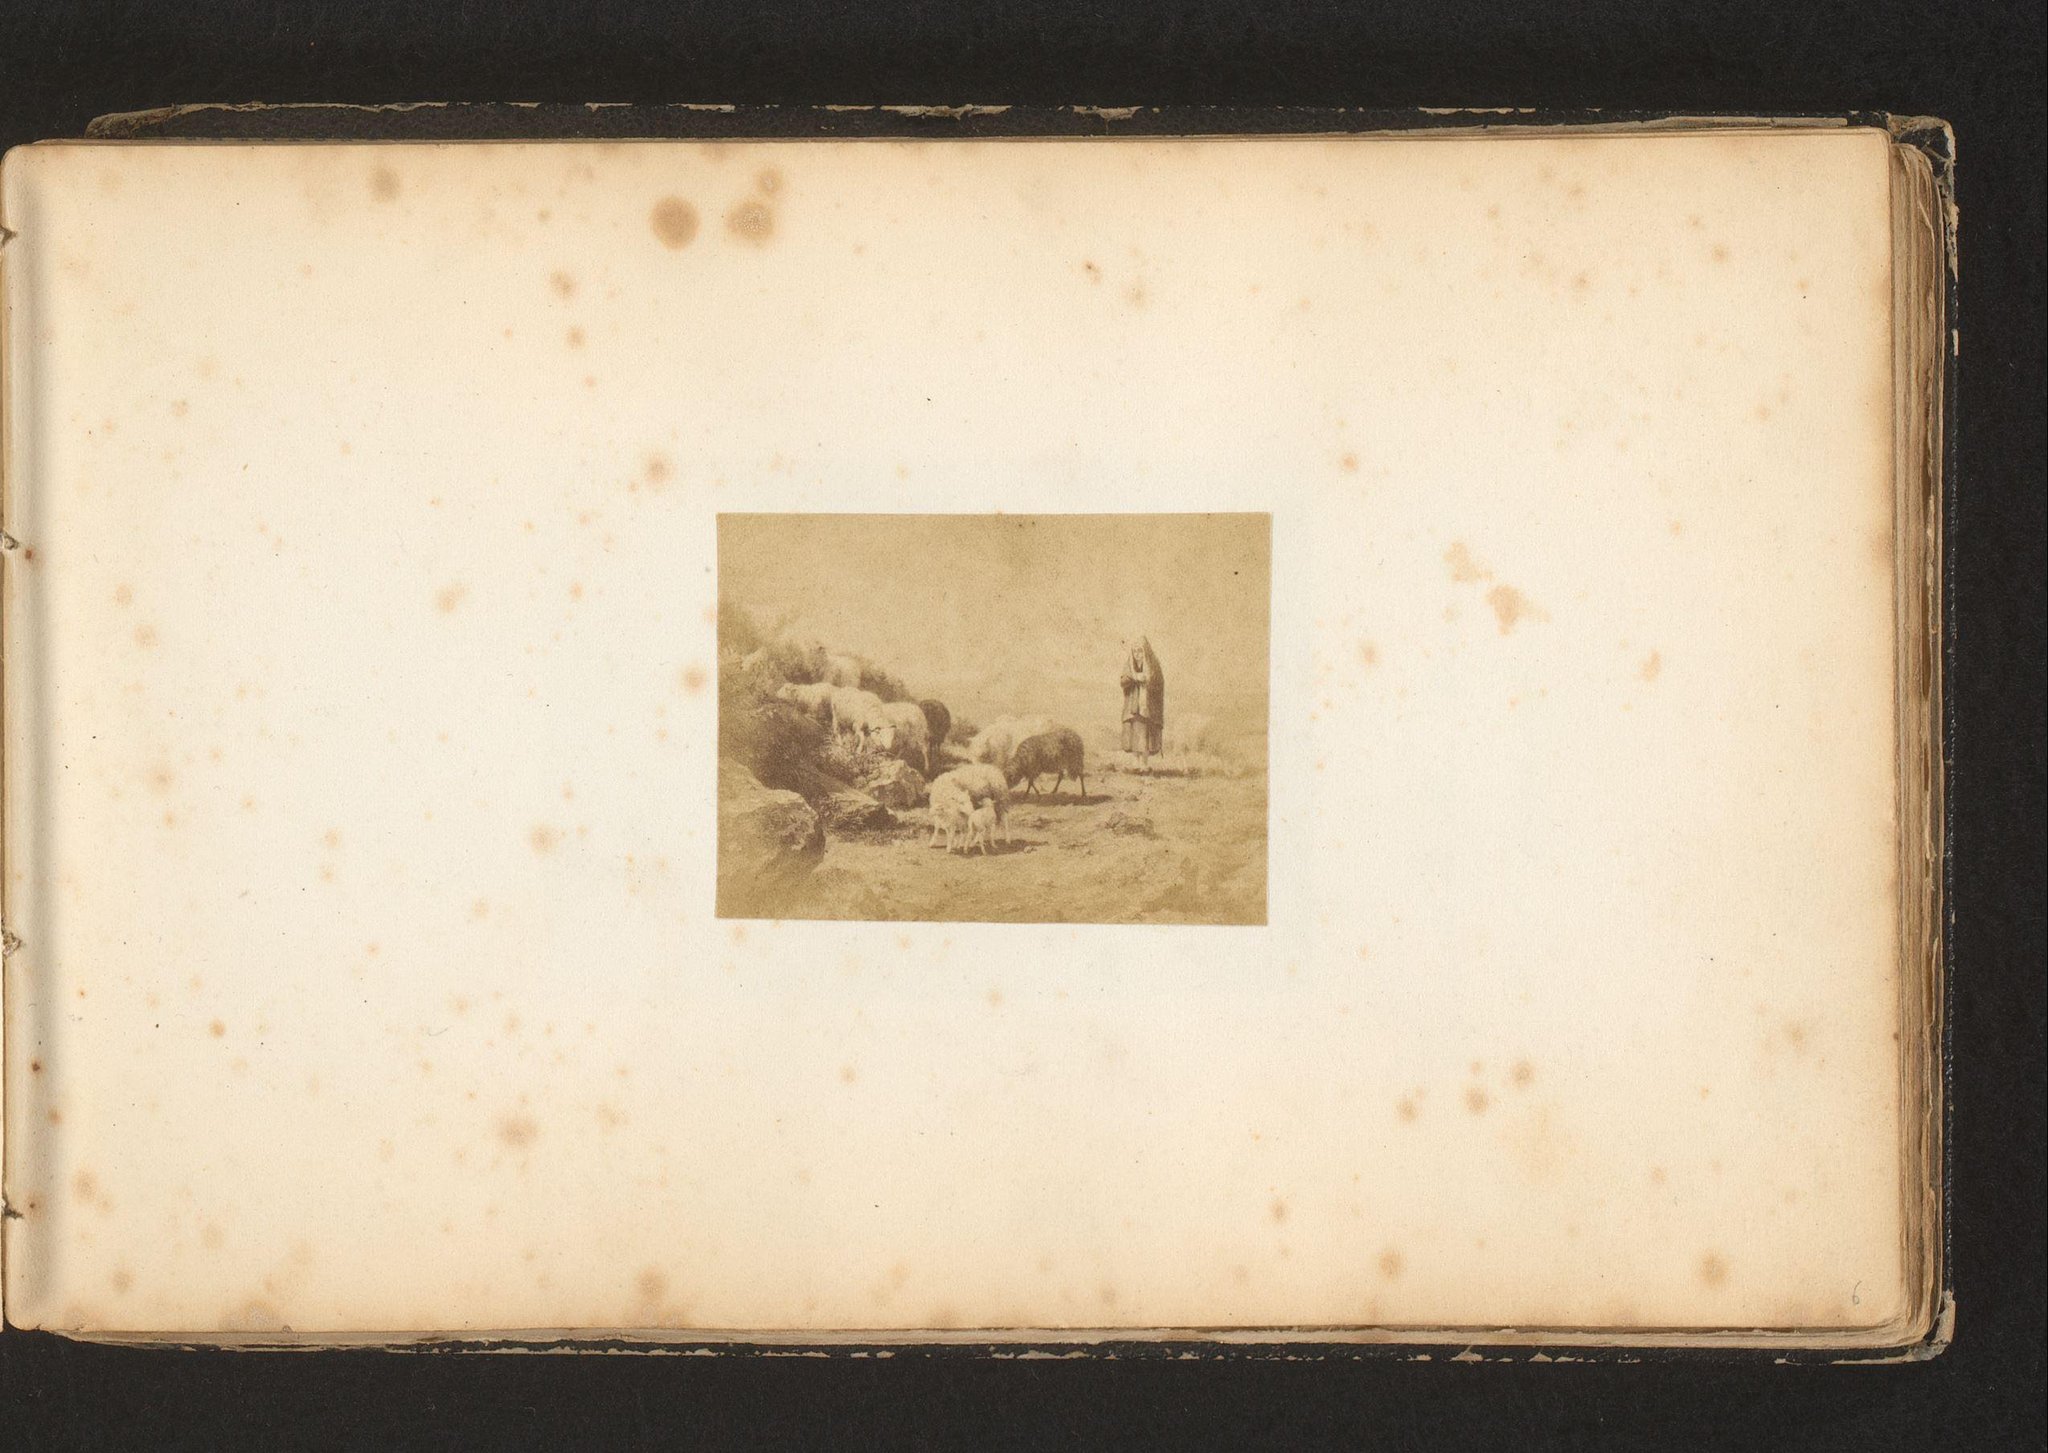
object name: photograph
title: Fotoreproductie van een schilderij van een kudde schapen met een herder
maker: Anonymous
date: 1860-1900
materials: photographic support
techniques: albumen print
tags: herding, herdsman, herdswoman, shepherd, shepherdess, cowherd, etc., sheep, painting, drawing and the graphic arts